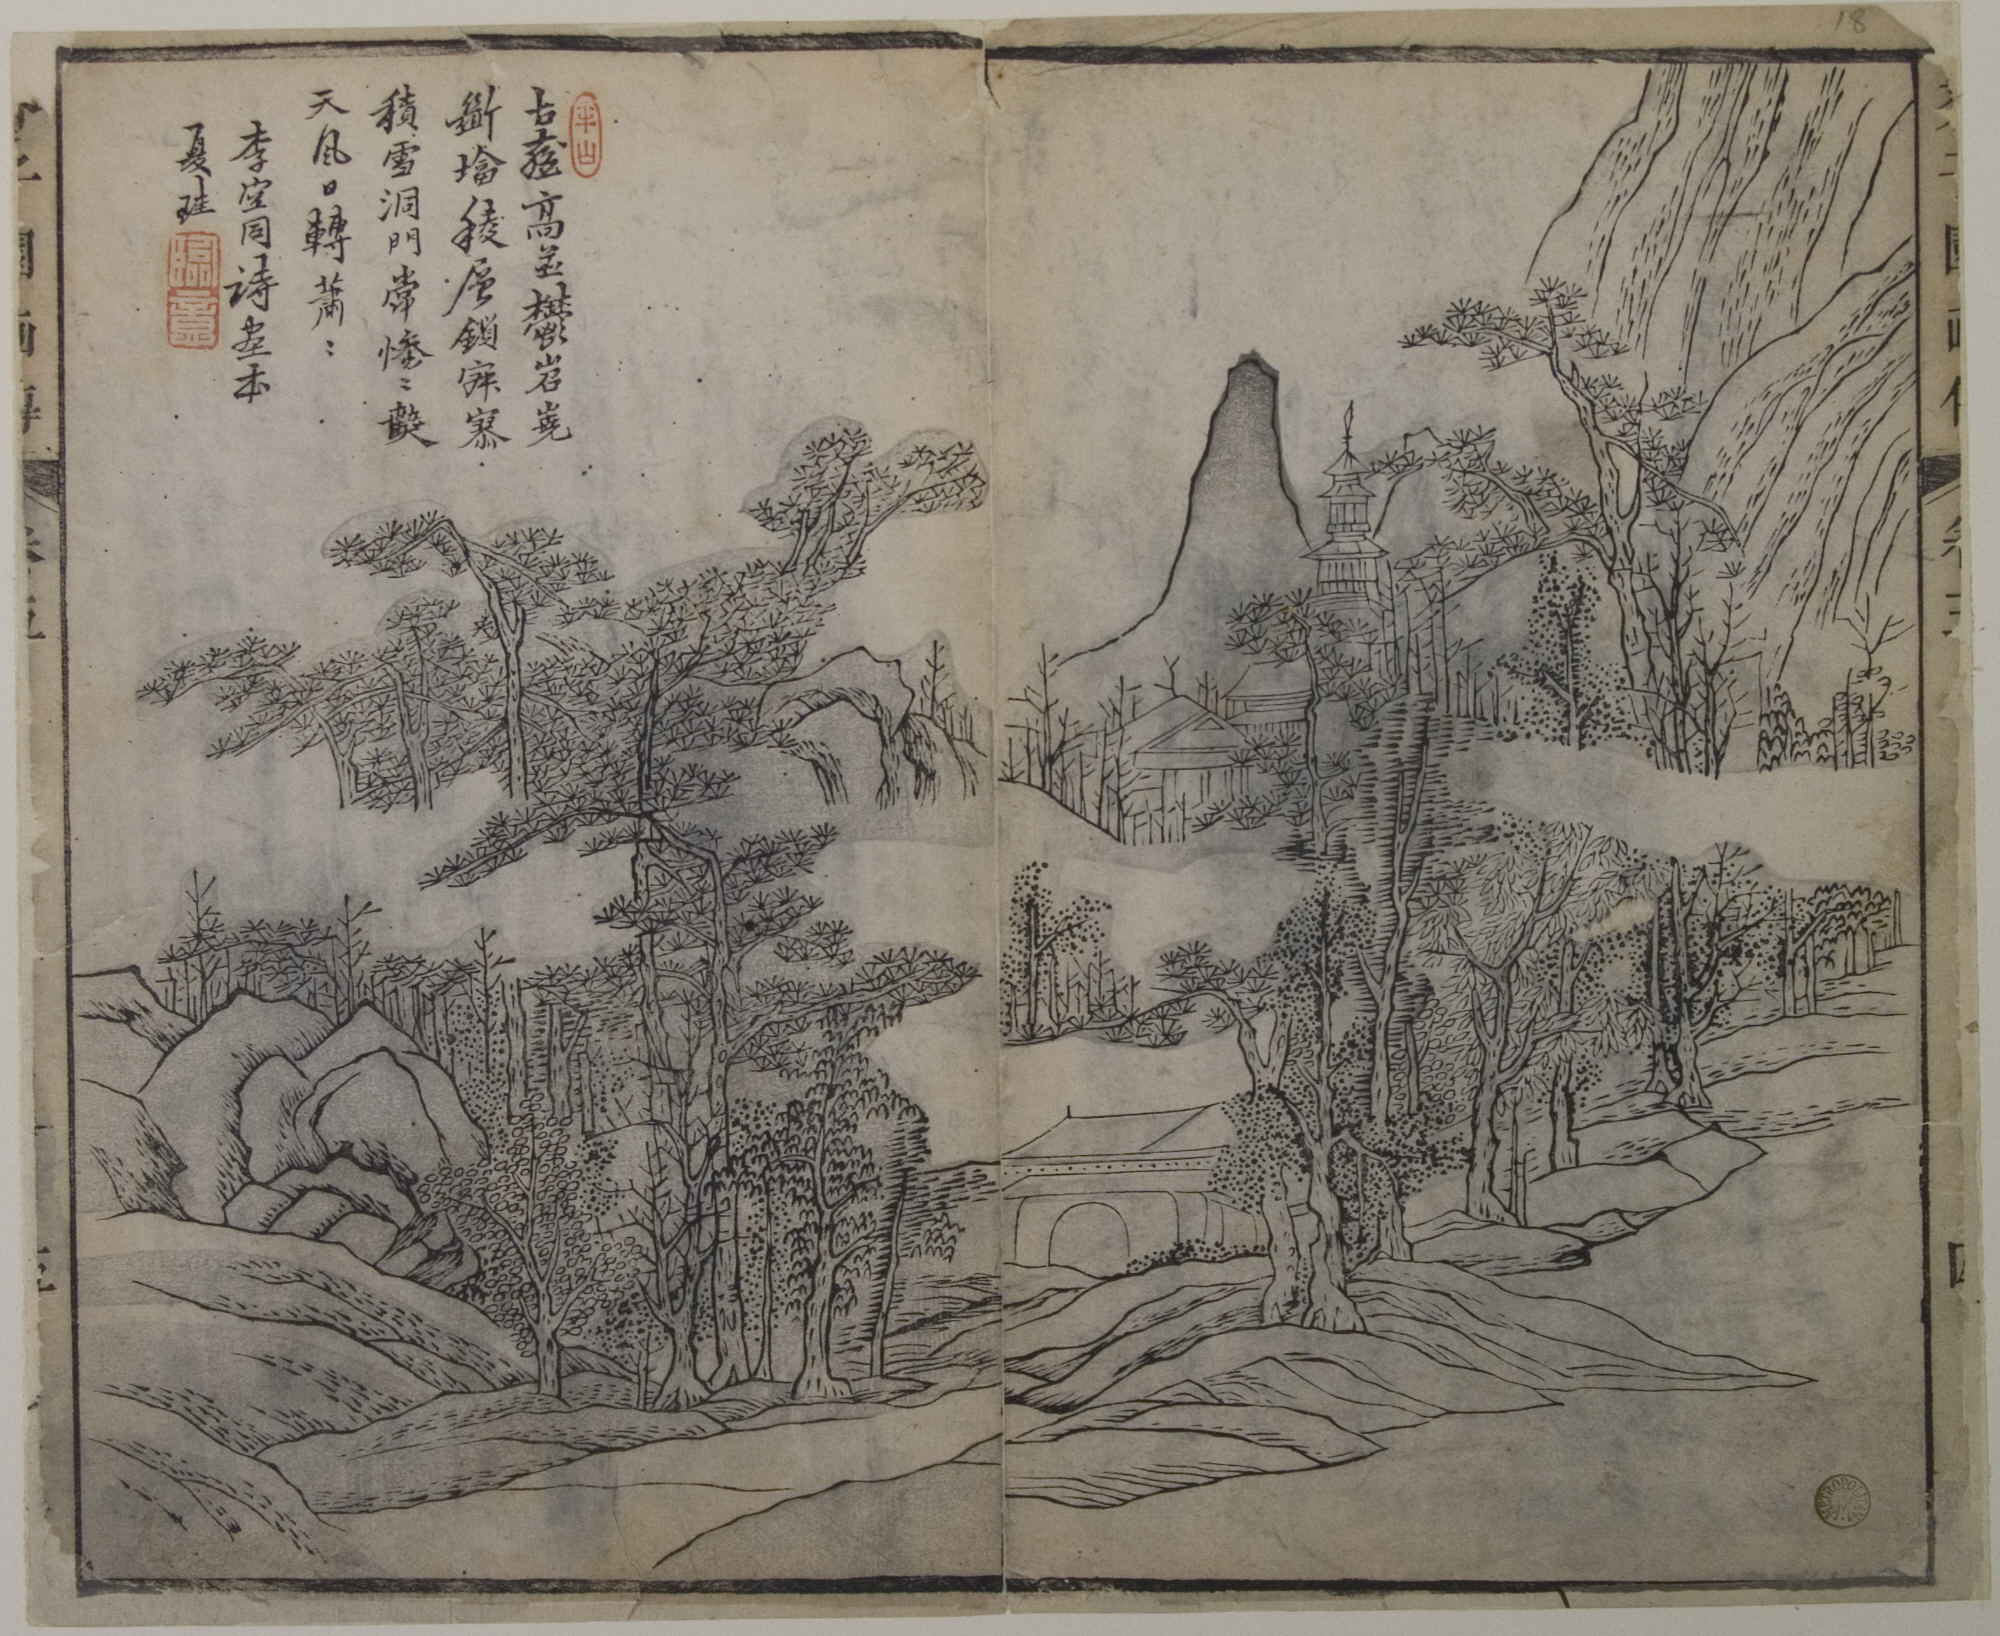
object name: print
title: Landscape after Xia Gui (active ca. 1195–1230), from the Mustard Seed Garden Manual of Painting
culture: chinese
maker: wang gai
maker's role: artist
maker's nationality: chinese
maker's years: 1645-1710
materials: ink, paper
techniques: woodblock print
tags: buildings,landscapes